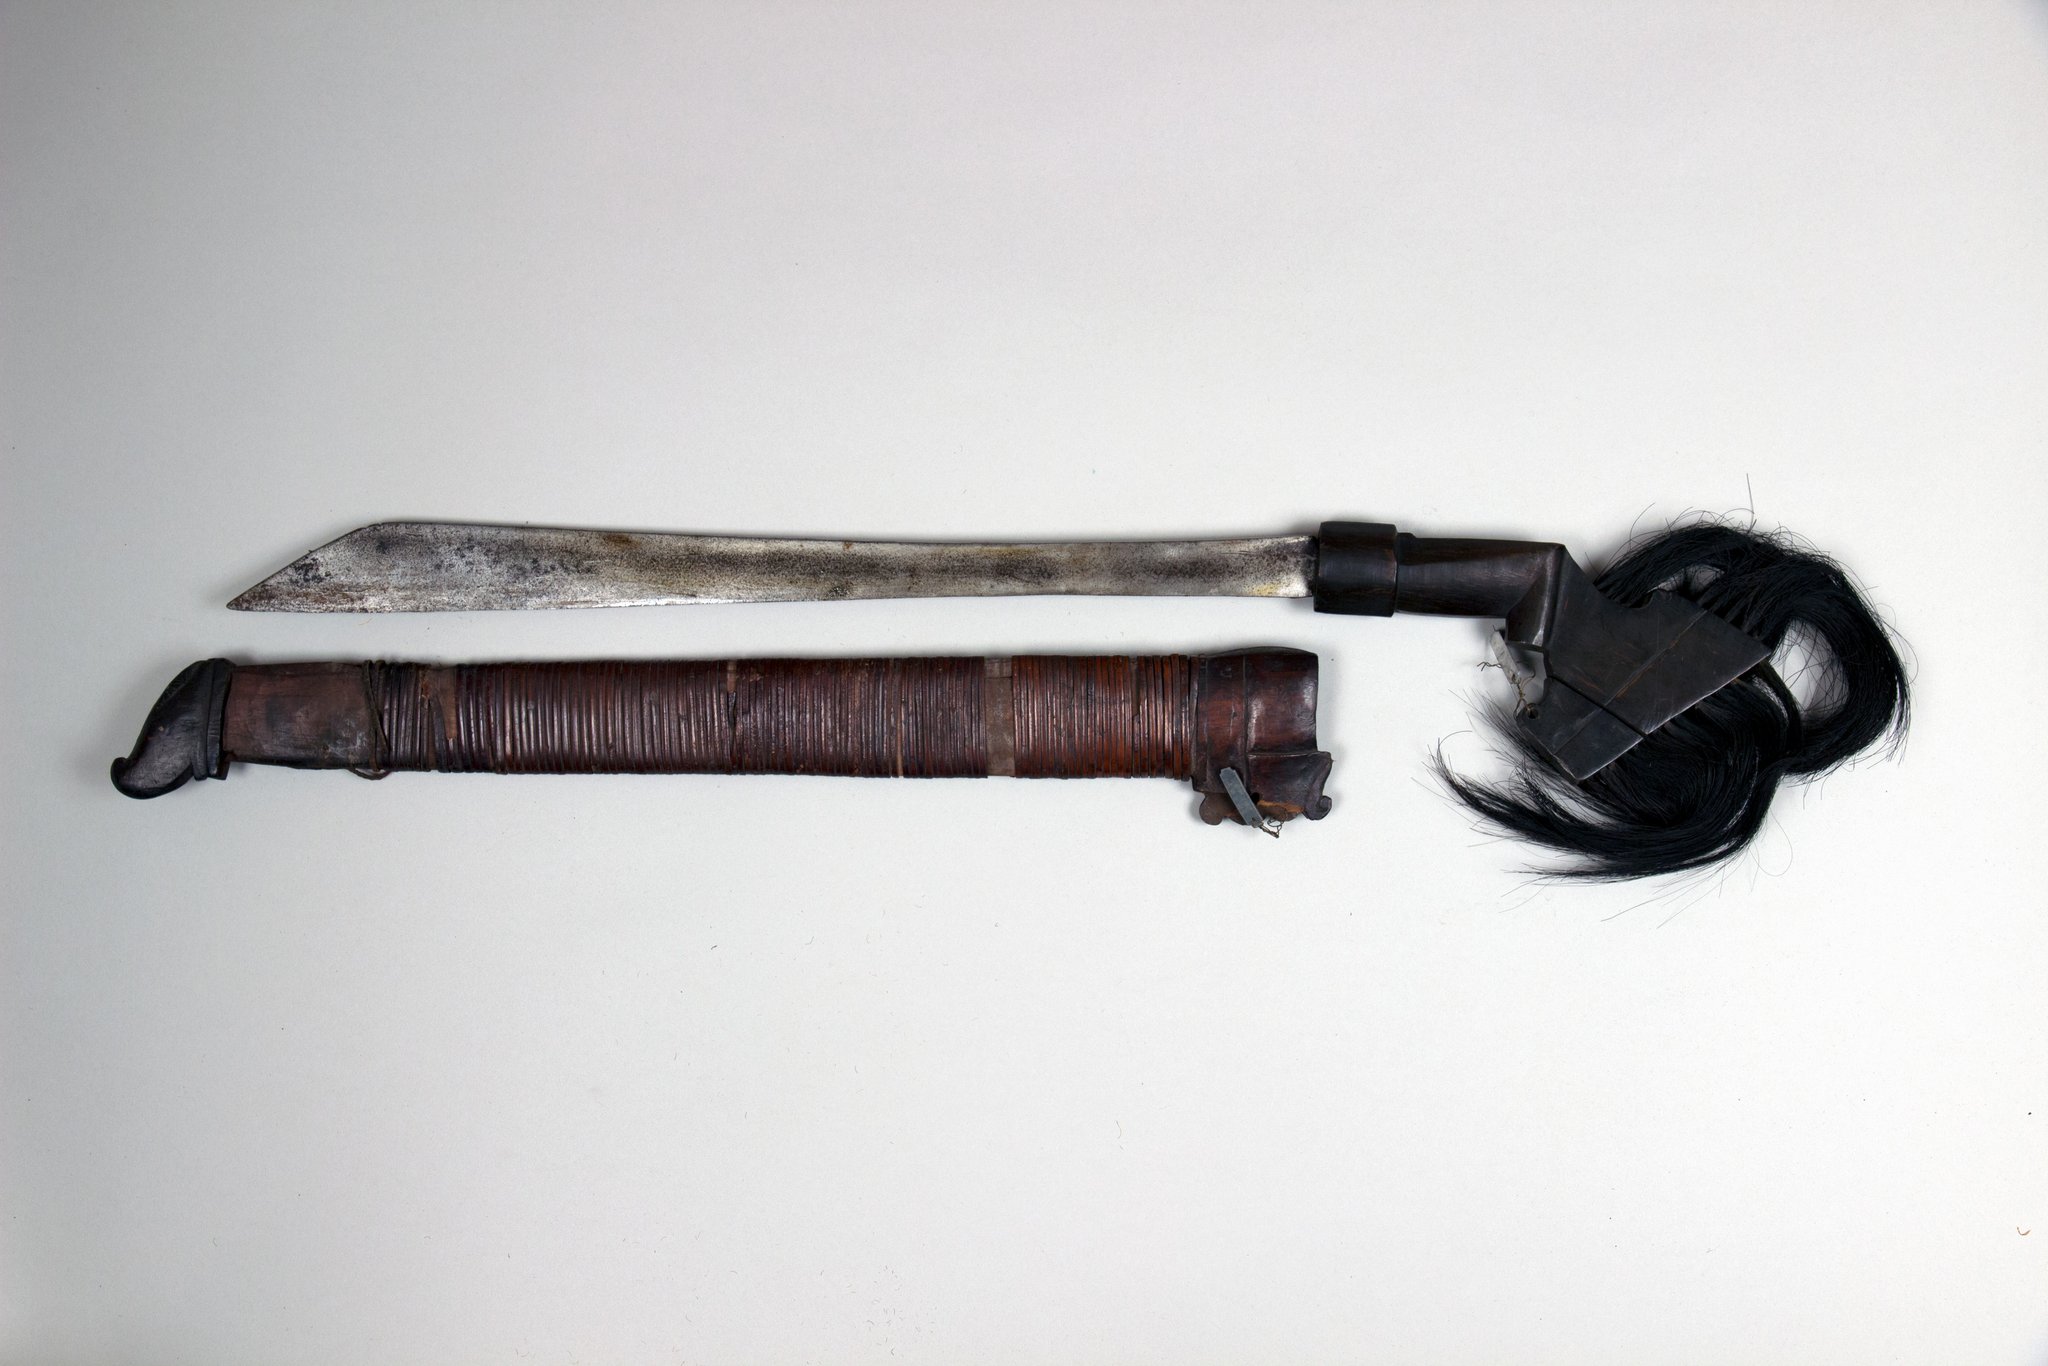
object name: sword with scabbard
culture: indonesian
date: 1701-1900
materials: hair, horn, rattan, wood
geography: indonesia